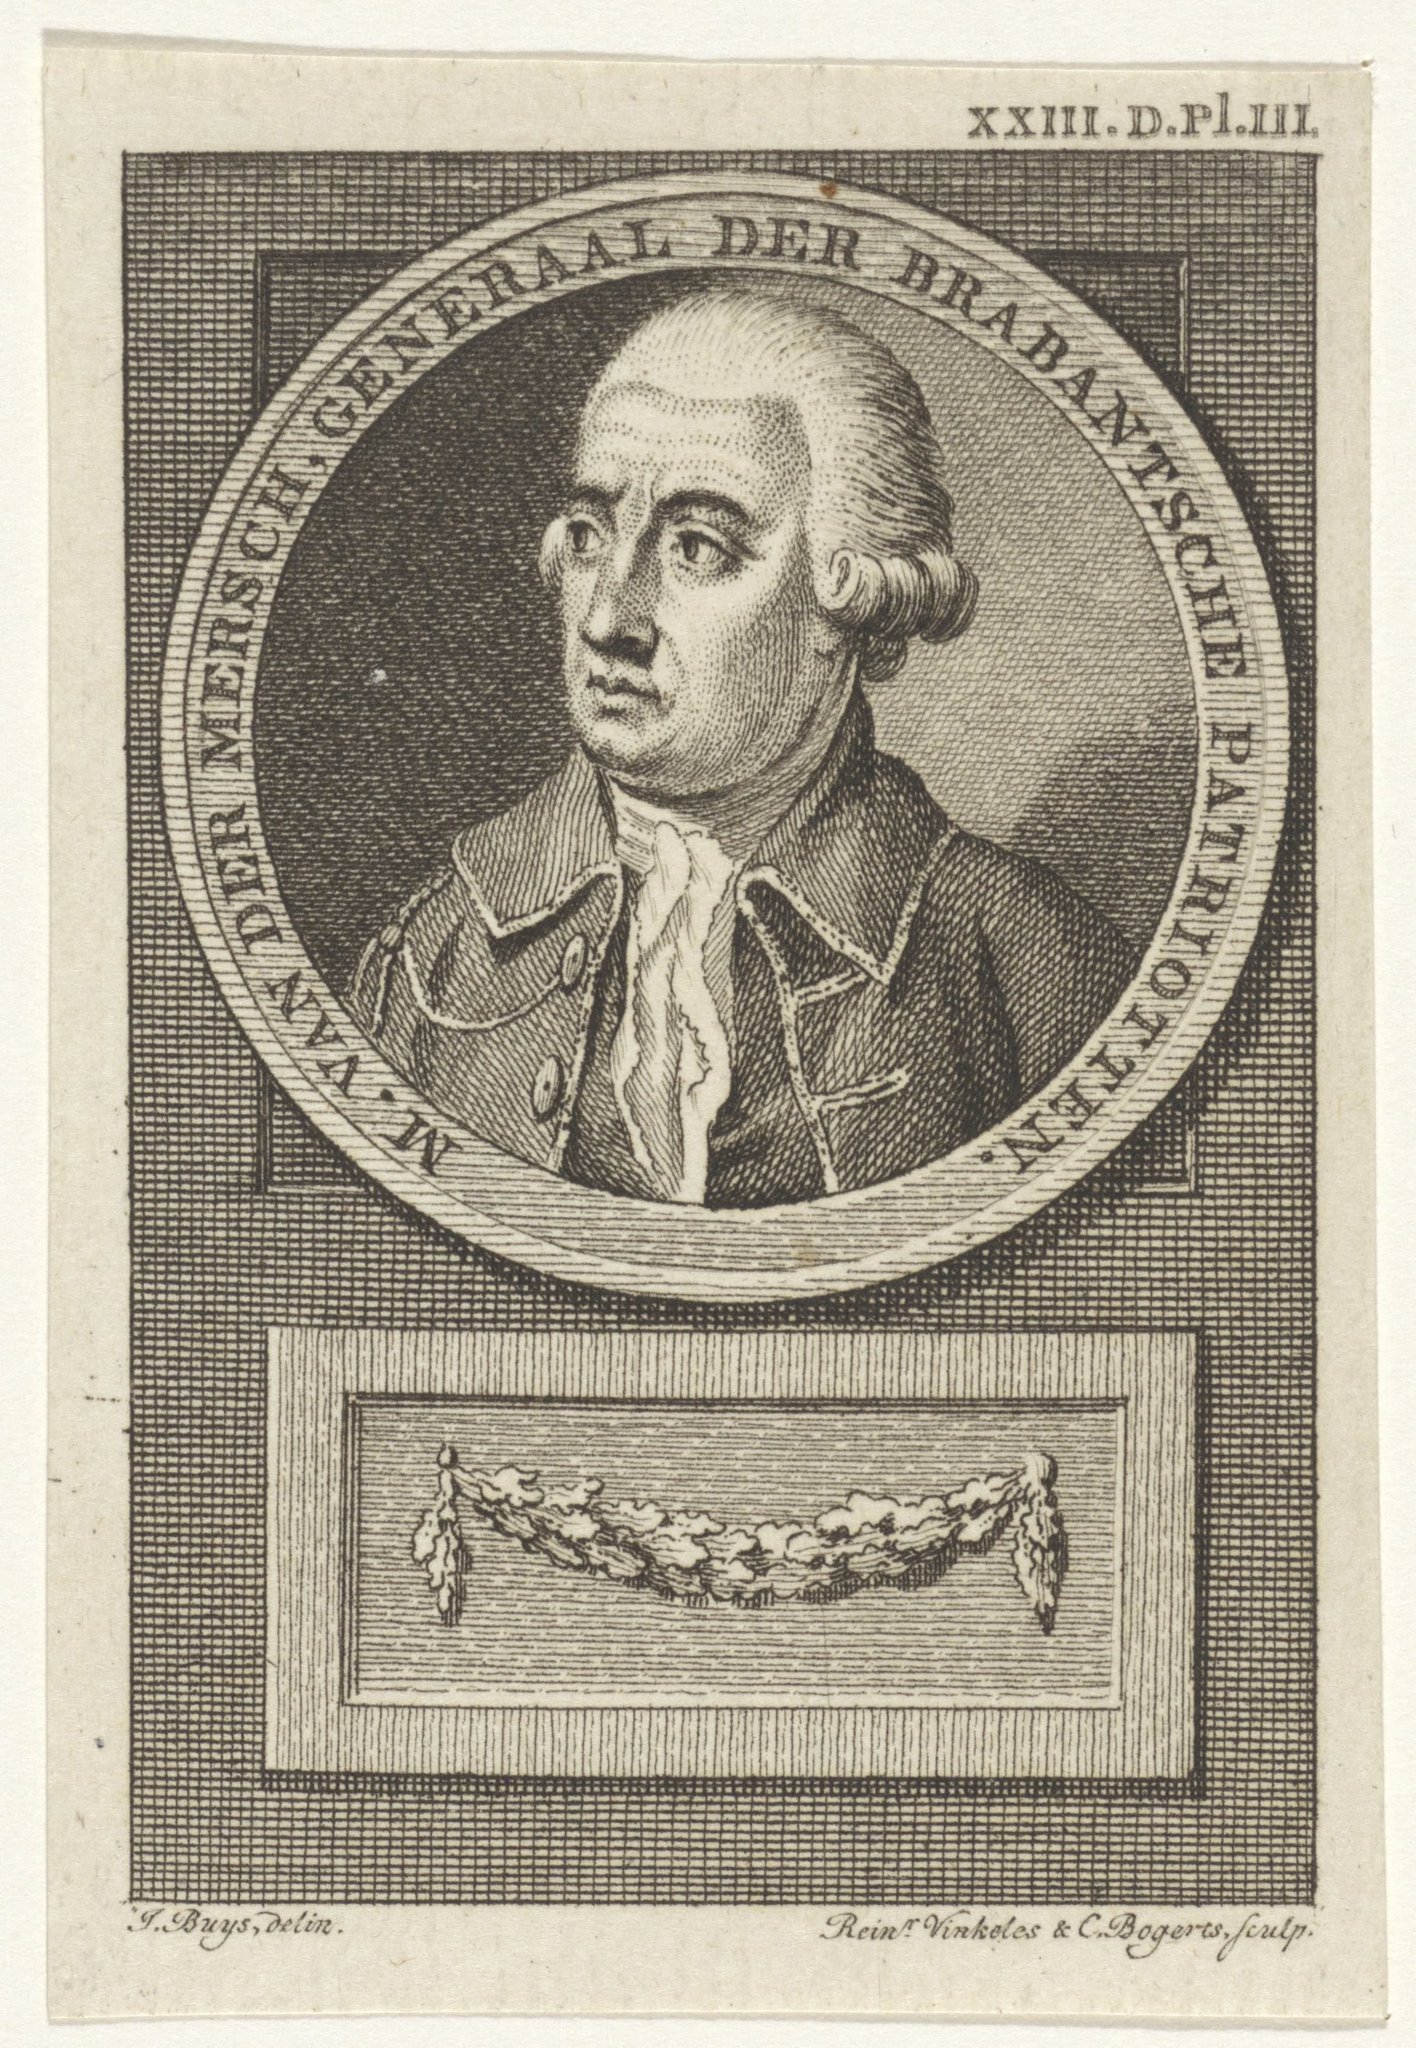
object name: print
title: Portret van Jean André van der Mersch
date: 1783-1795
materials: paper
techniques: engraving, etching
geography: amsterdam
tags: luitenant-generaal, jan andries vander mersch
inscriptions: collector's mark: Lugt 2228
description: Prent gebruikt in: Fokke, Jan. Geschiedenissen der Vereenigde Nederlanden voor de vaderlandsche jeugd Ie-XXVste deel. Amsterdam: Johannes Allart, 1783-1795. Deel XXIII.